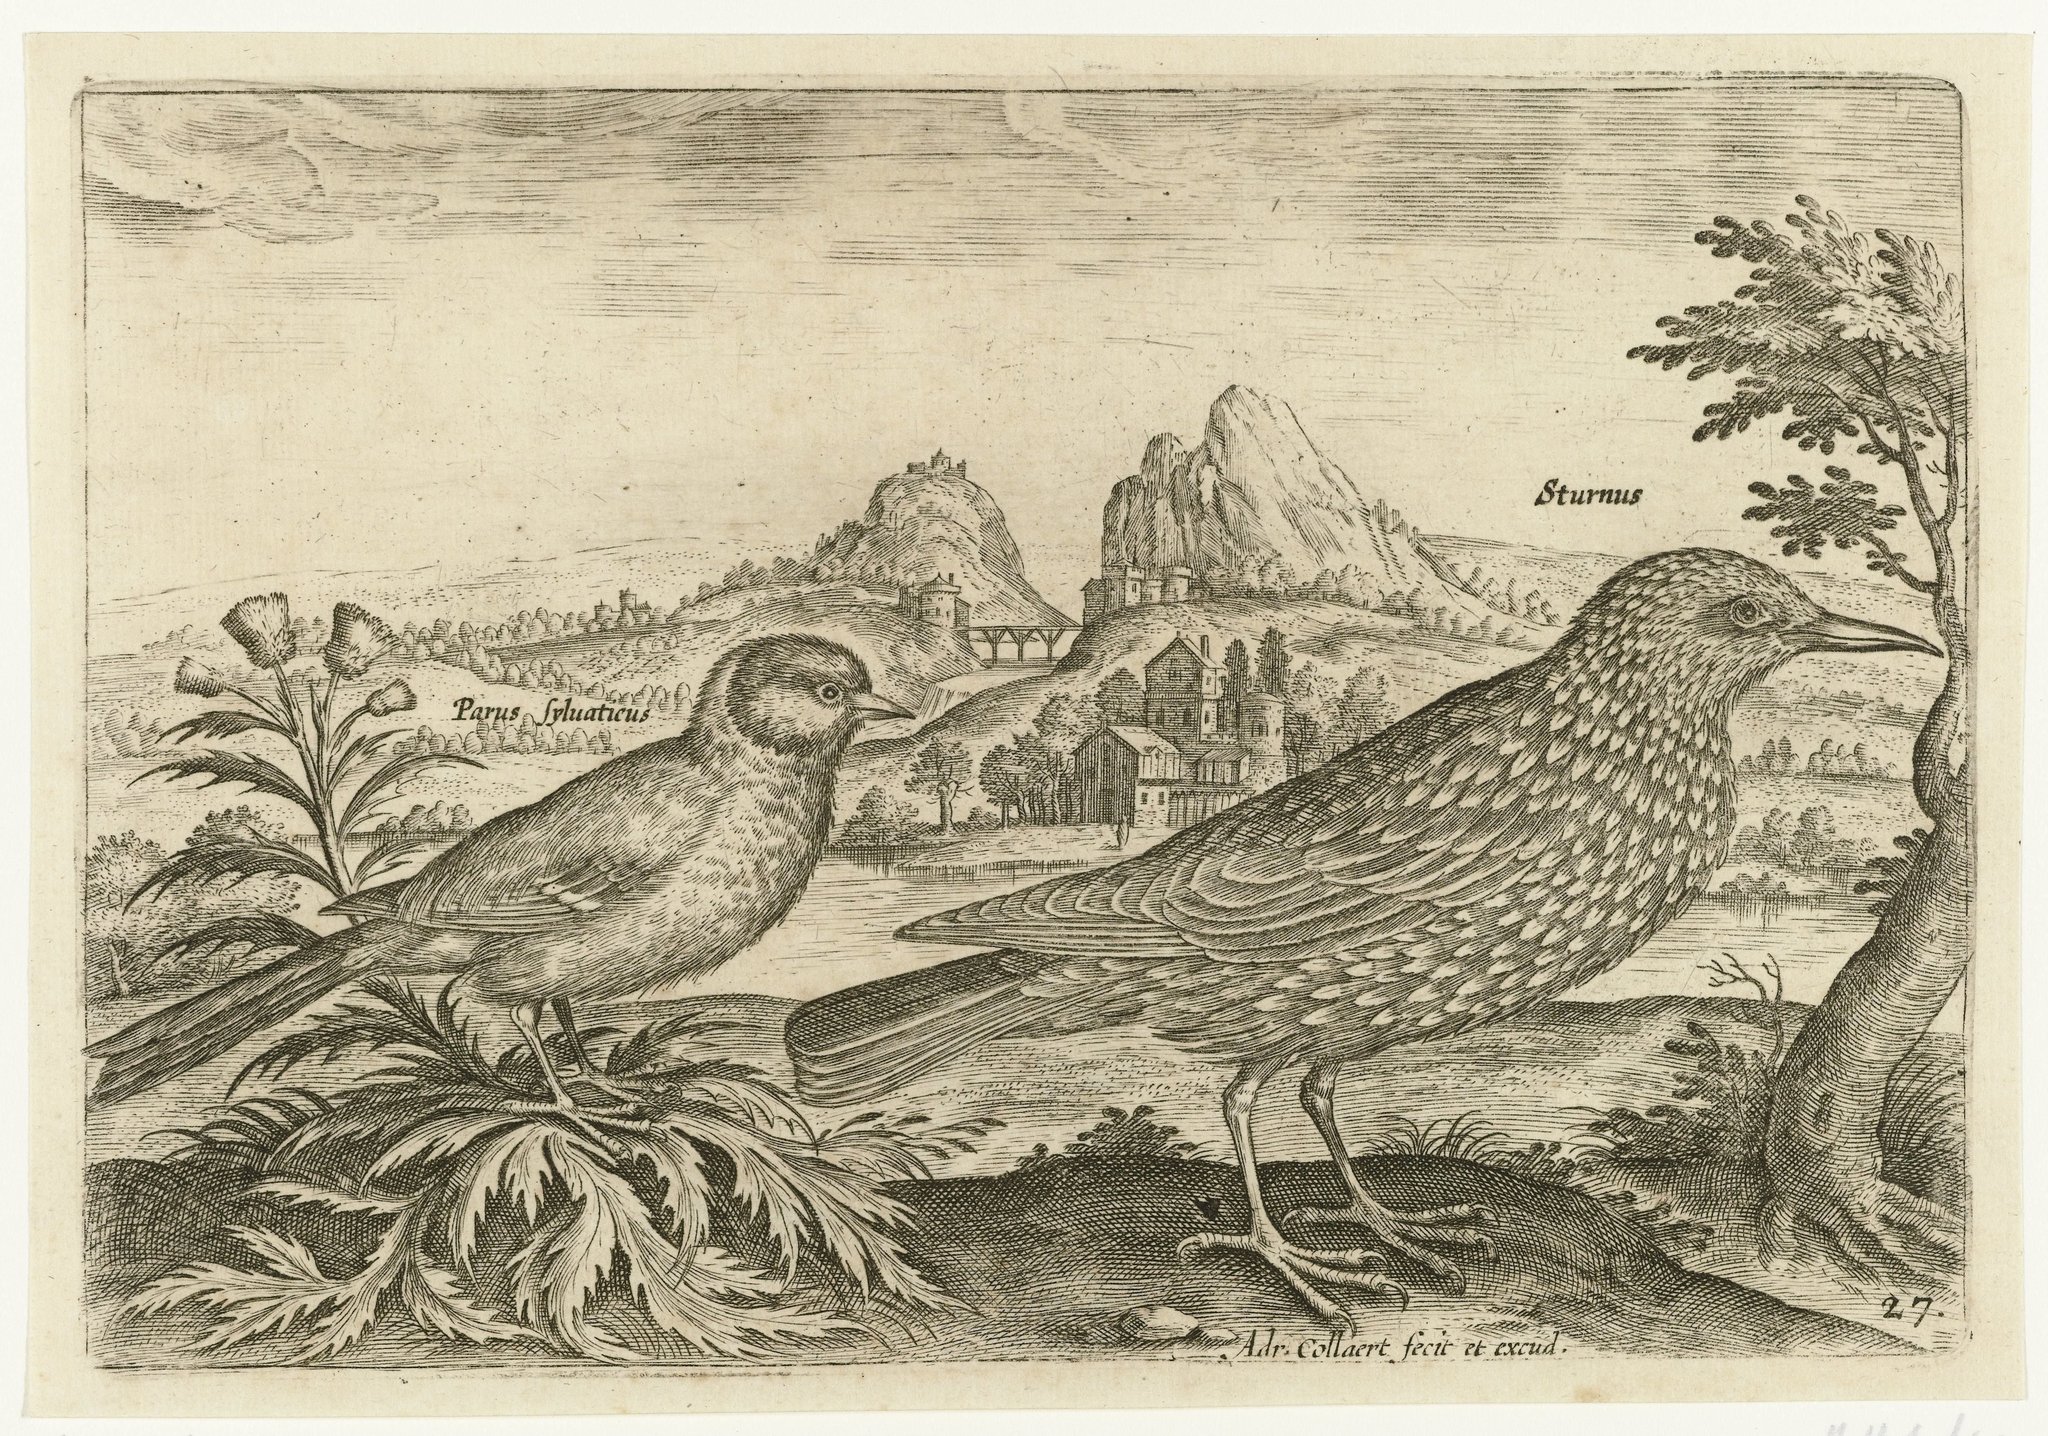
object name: print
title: Twee vogels in een landschap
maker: adriaen collaert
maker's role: draughtsman, print maker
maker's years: 1560-1618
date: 1598-1602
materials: paper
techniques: engraving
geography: antwerp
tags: city-view, and landscape with man-made constructions, song-birds: great tit, song-birds: starling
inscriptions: collector's mark: Lugt 2228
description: Een spreeuw en een koolmees in een landschap. De prent maakt deel uit van een serie met vogels als onderwerp.